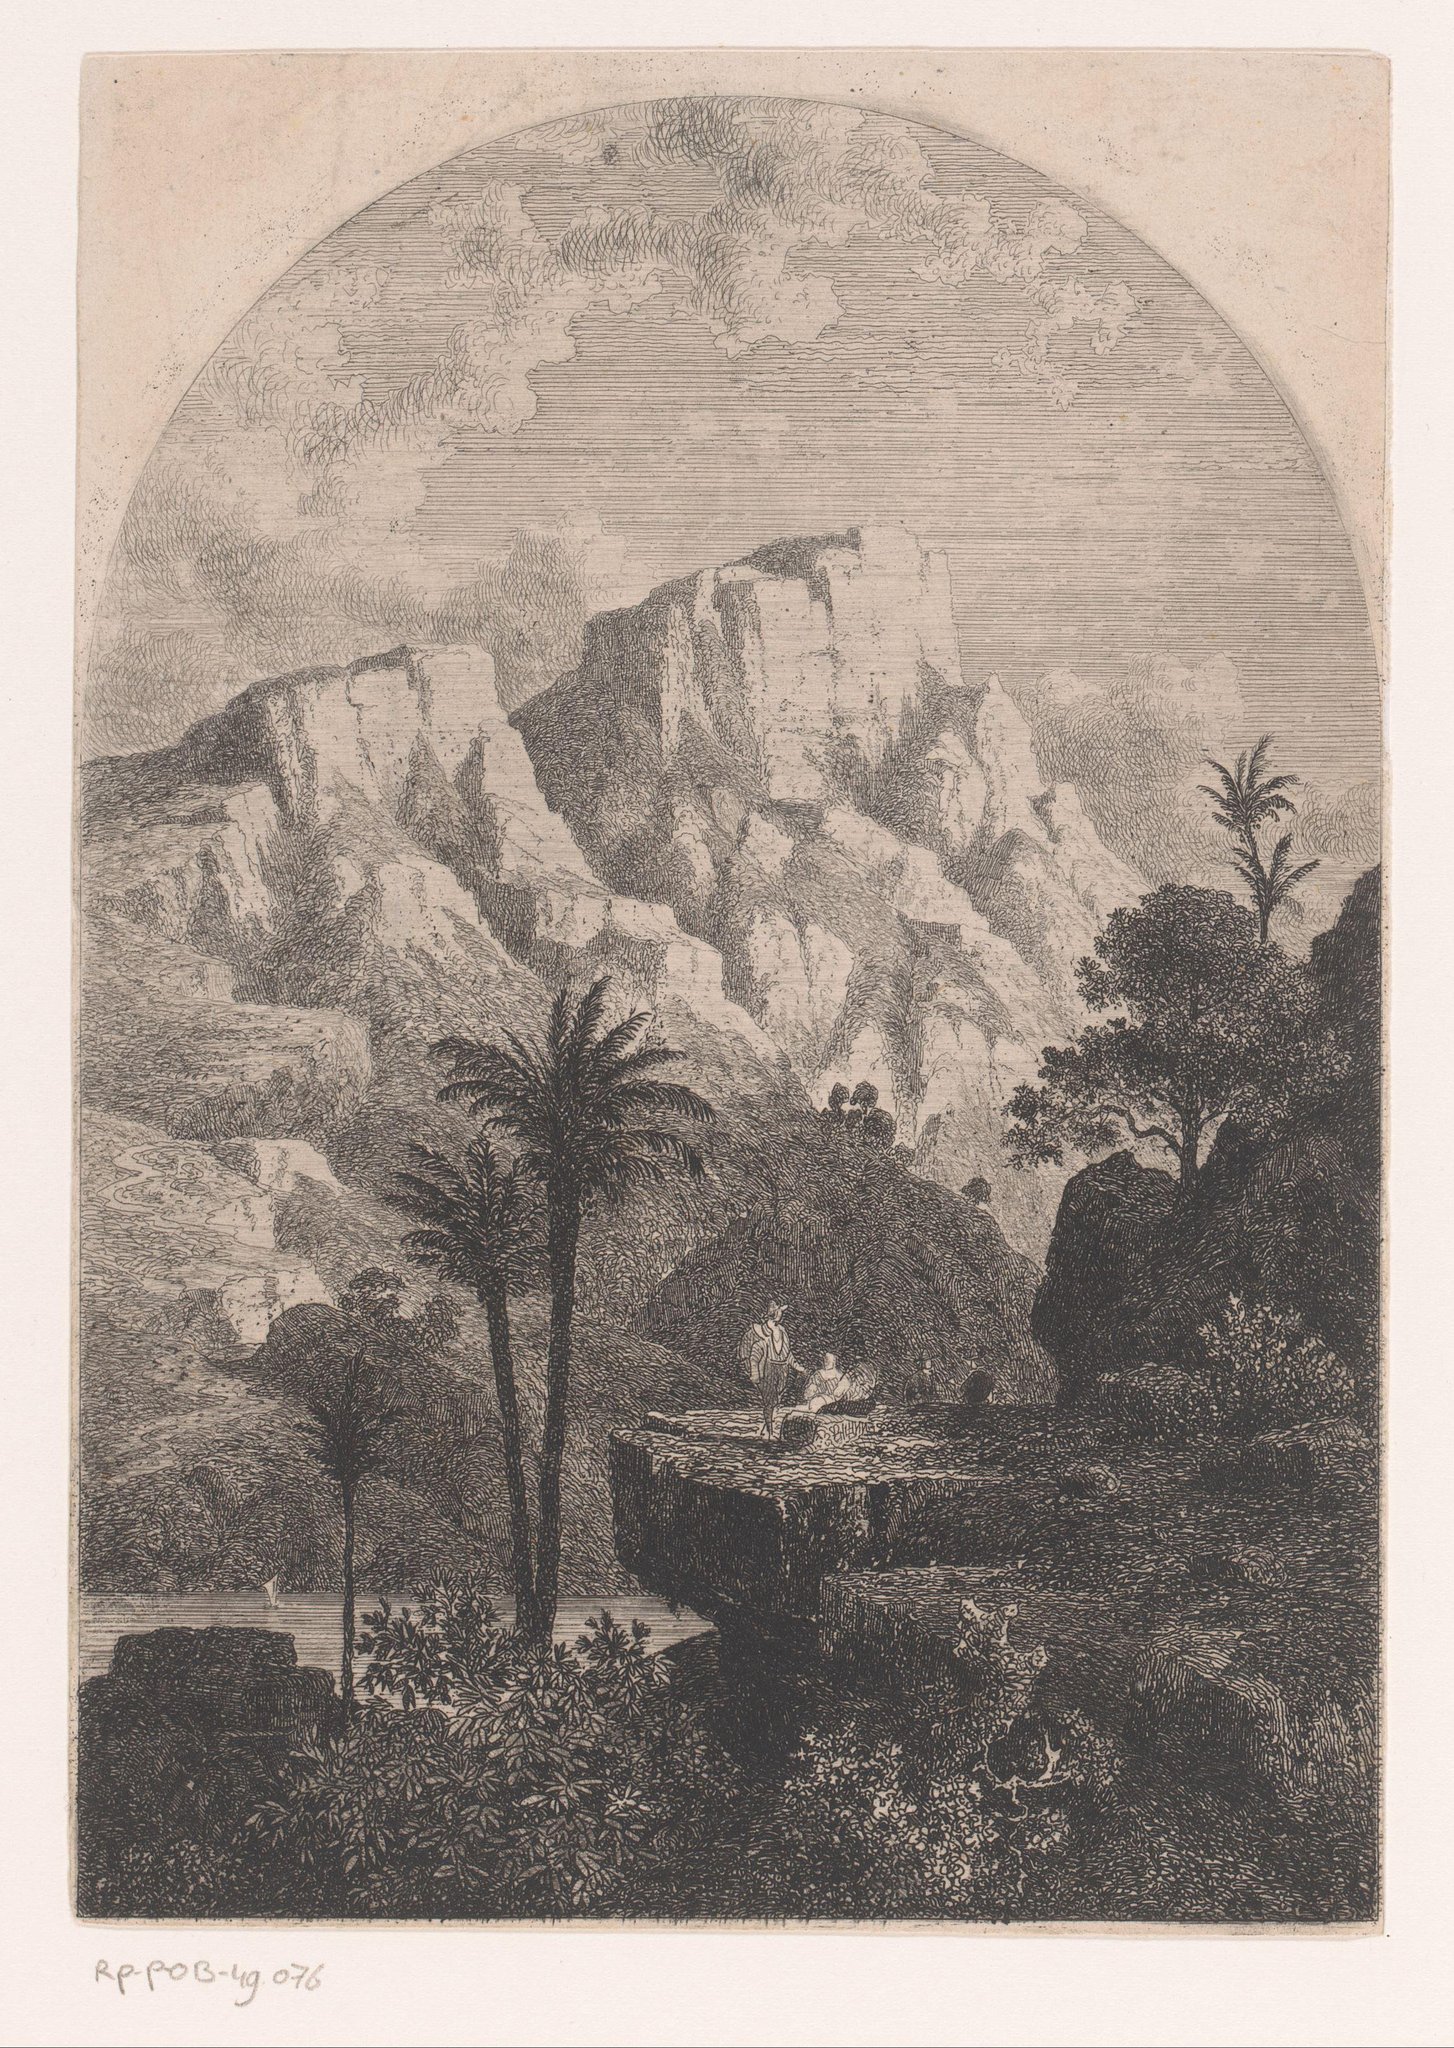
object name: print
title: Berglandschap met rustende figuren op een rots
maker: guillaume van der hecht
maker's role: print maker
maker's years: 1817-1891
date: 1827-1879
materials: paper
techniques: etching, intaglio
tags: mountains (+ landscape with figures, staffage)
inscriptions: collector's mark: Lugt 2228